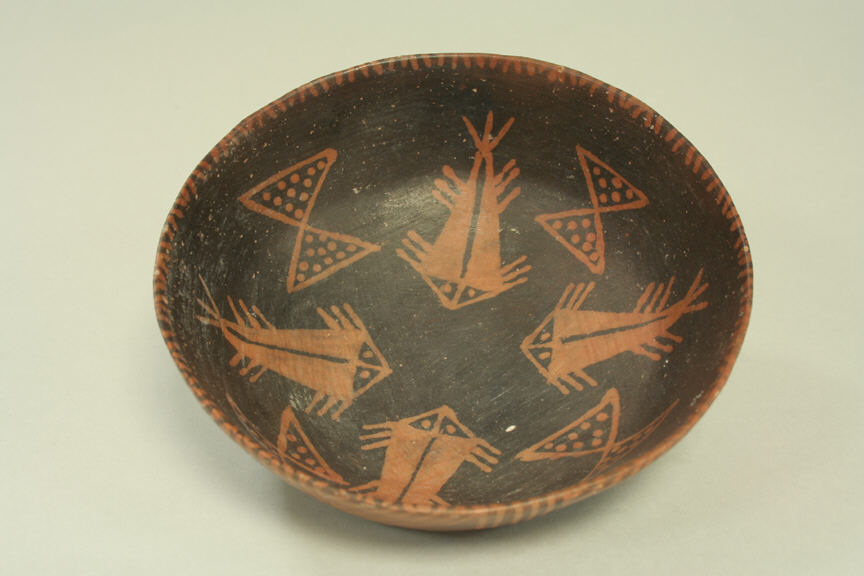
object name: bowl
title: Orangeware Bowl with Fish Motif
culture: paracas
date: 200-101 BCE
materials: ceramic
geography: peru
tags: fish